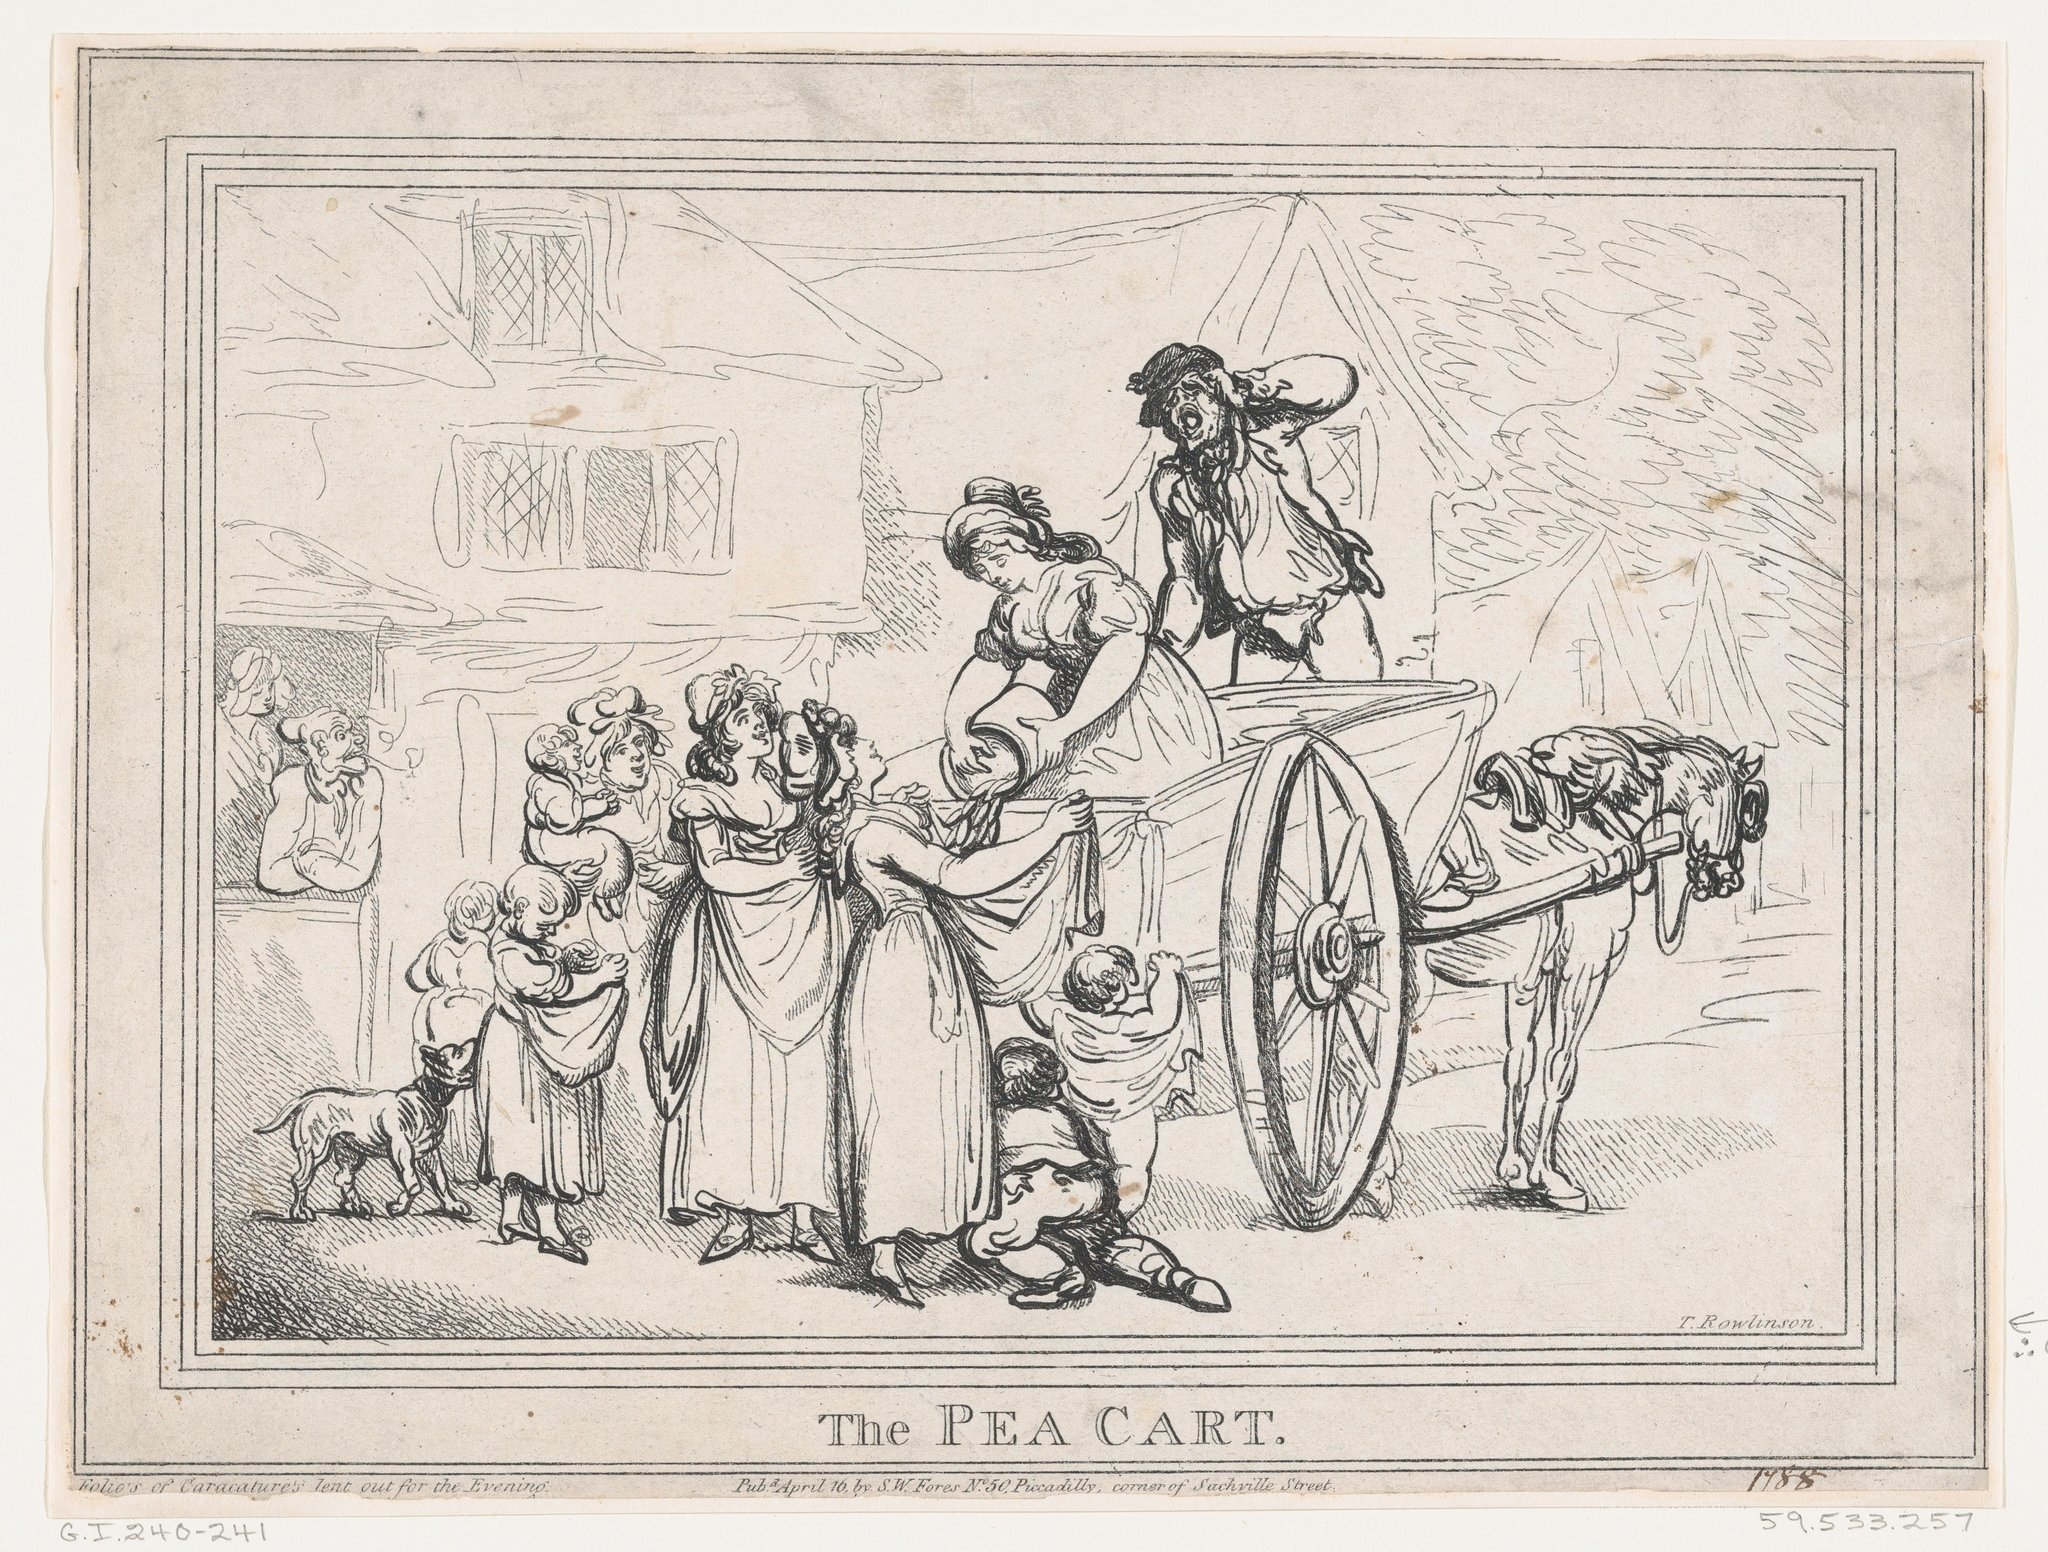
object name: print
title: The Pea Cart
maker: thomas rowlandson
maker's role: artist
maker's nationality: british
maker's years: 1757-1827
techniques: etching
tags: men,women,dogs,horses,carriages